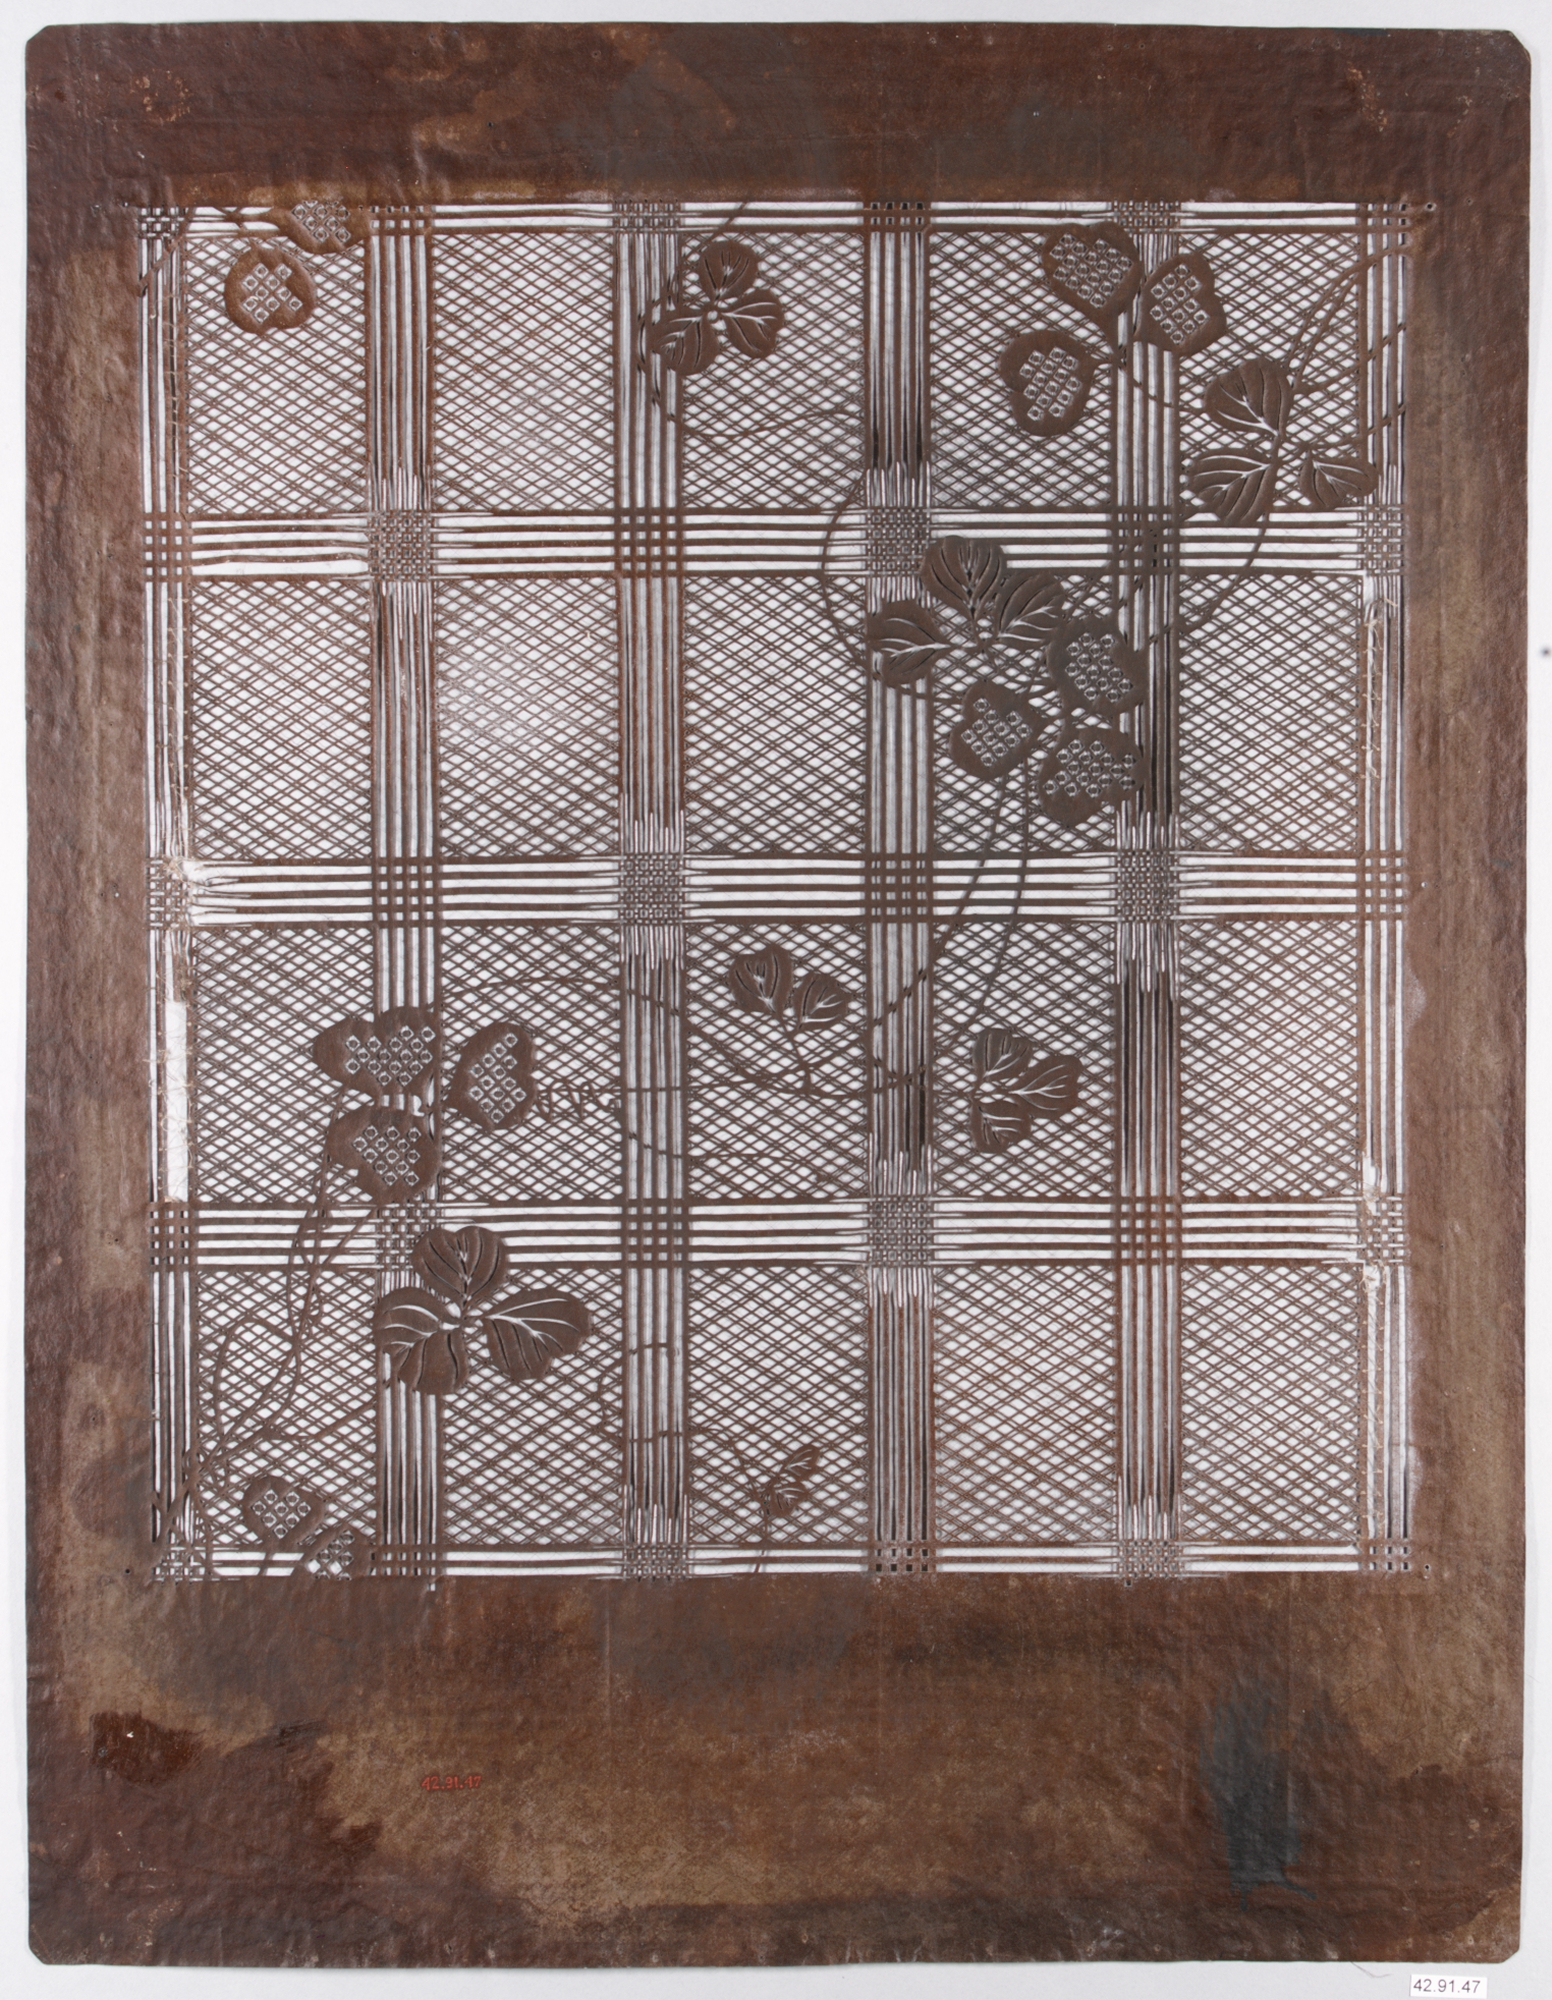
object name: stencil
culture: japanese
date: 1801-1900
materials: paper, silk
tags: flowers